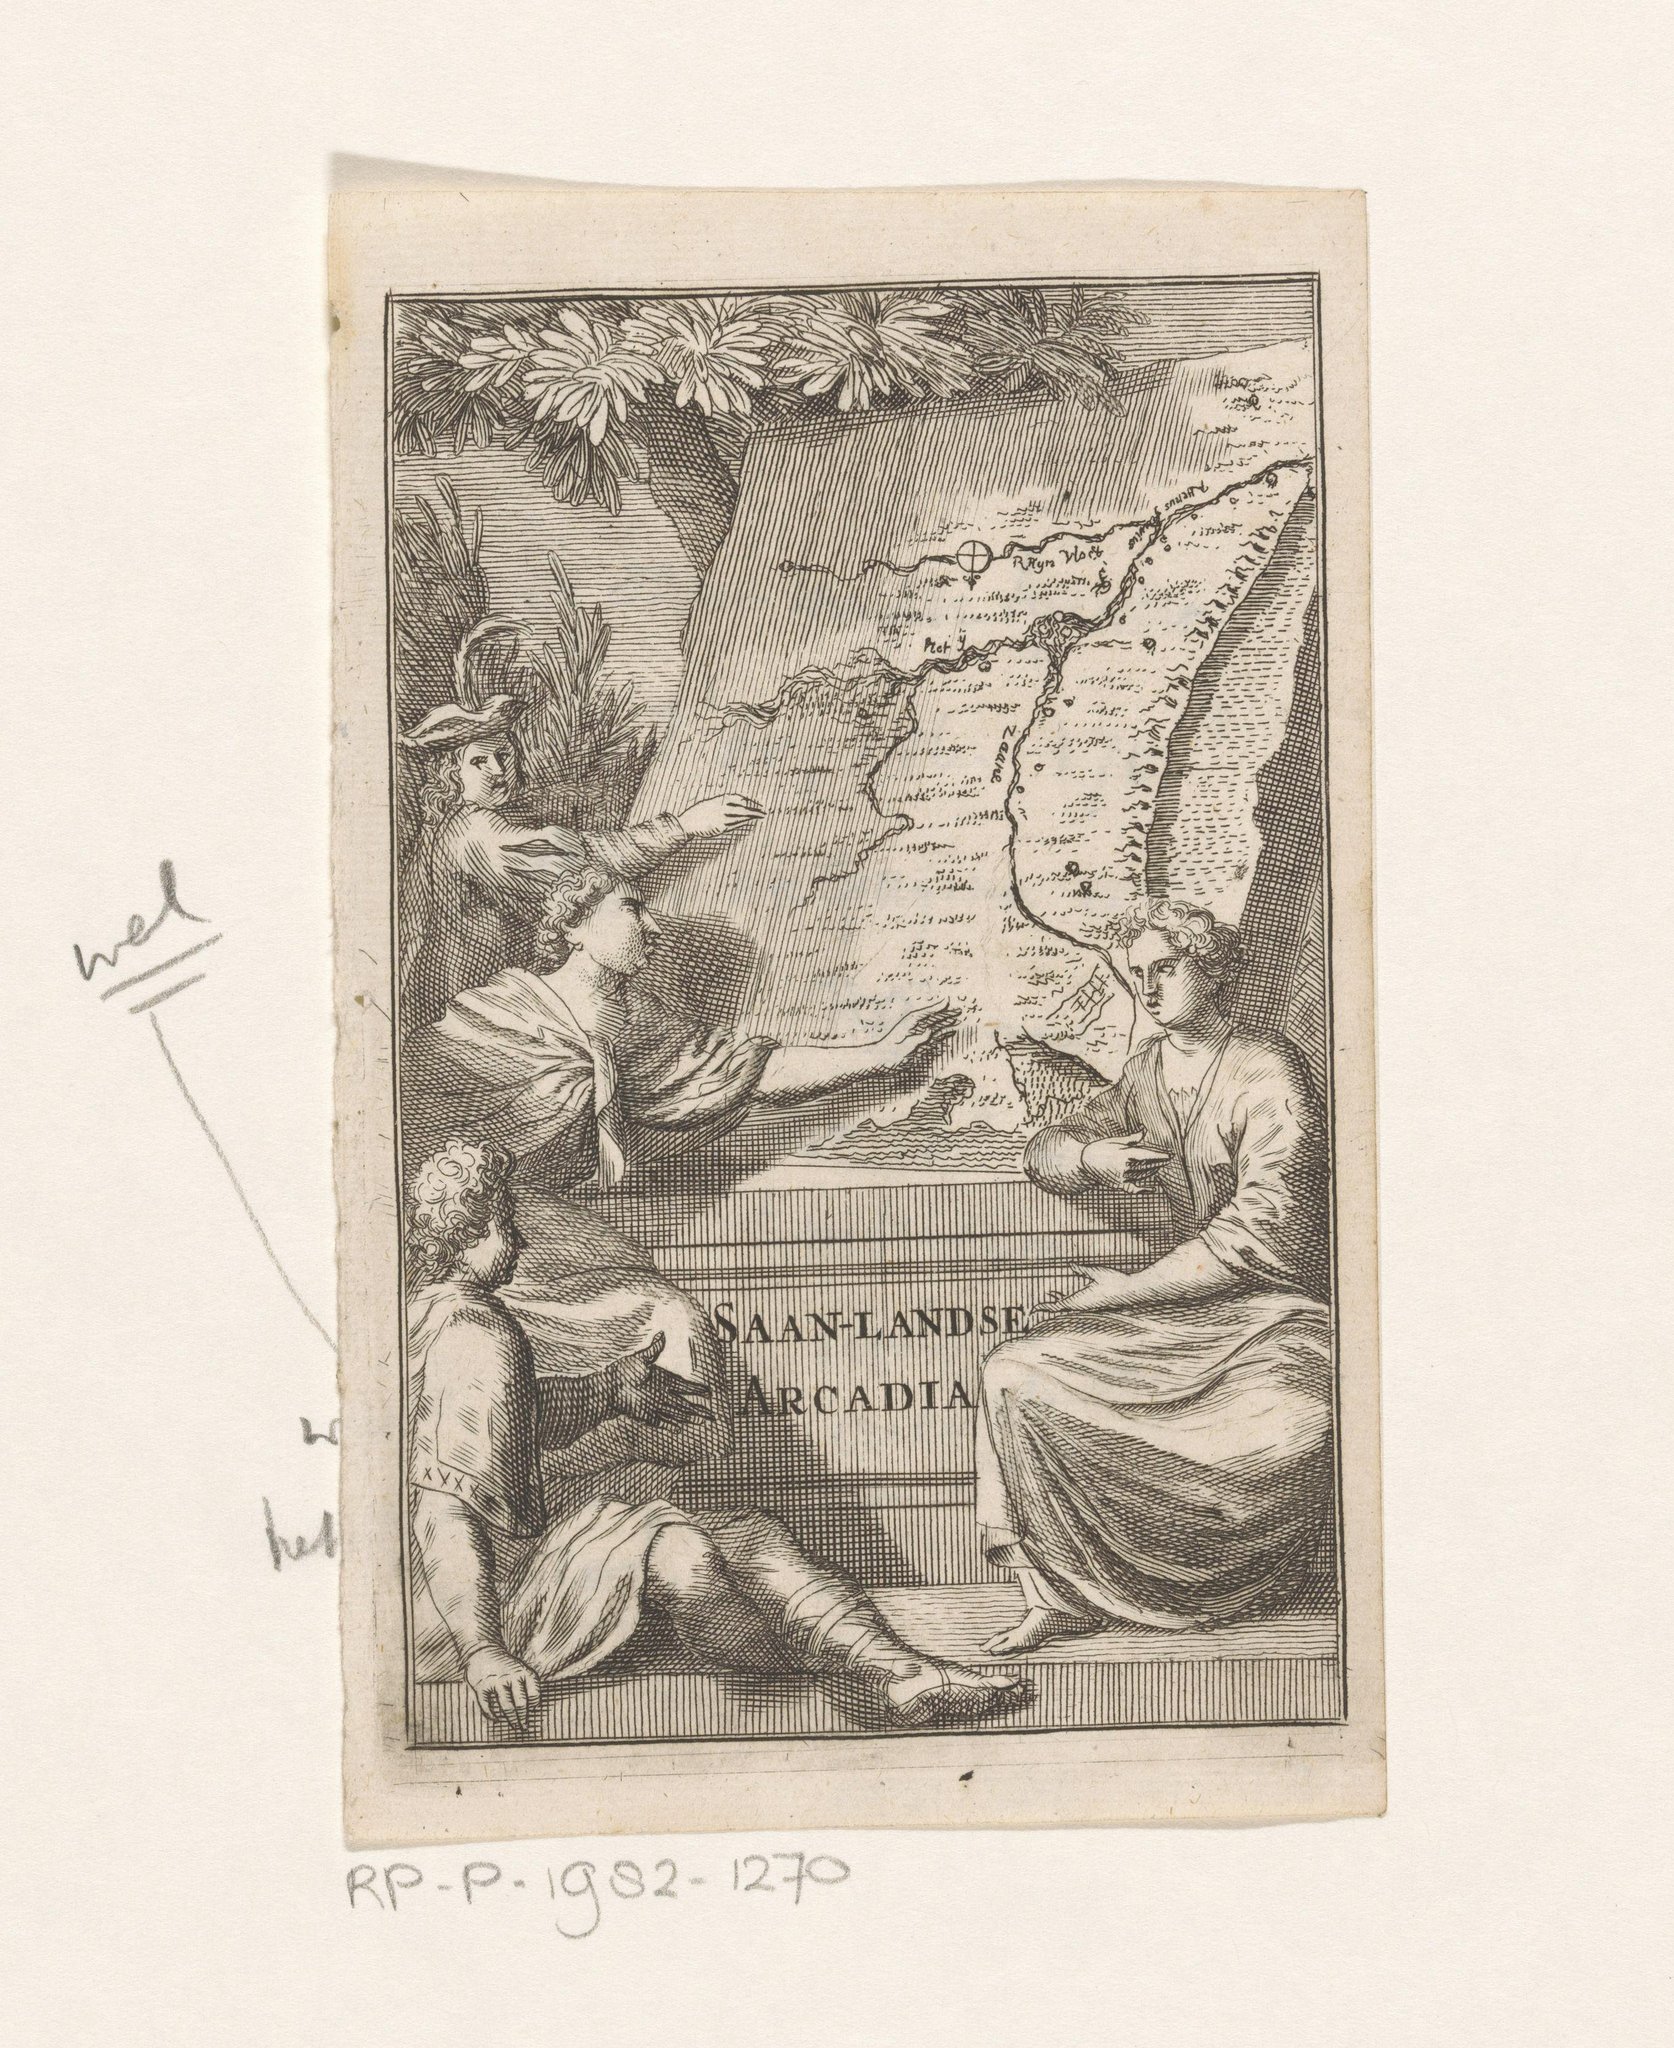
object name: print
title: Figuren rondom kaart van Zaanland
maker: pieter van den berge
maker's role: draughtsman, print maker, printer, publisher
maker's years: 1659-1737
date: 1702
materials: paper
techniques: etching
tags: maps, atlases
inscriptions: collector's mark: Lugt 2228, collector's mark: Lugt 2760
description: Prent uit: Soeteboom, Hendrik. Oud-Heeden van Zaan-land Stavoren Vronen en Waterland. I deel. Amsterdam: Linnig van Koppenol, Willem, 1702.